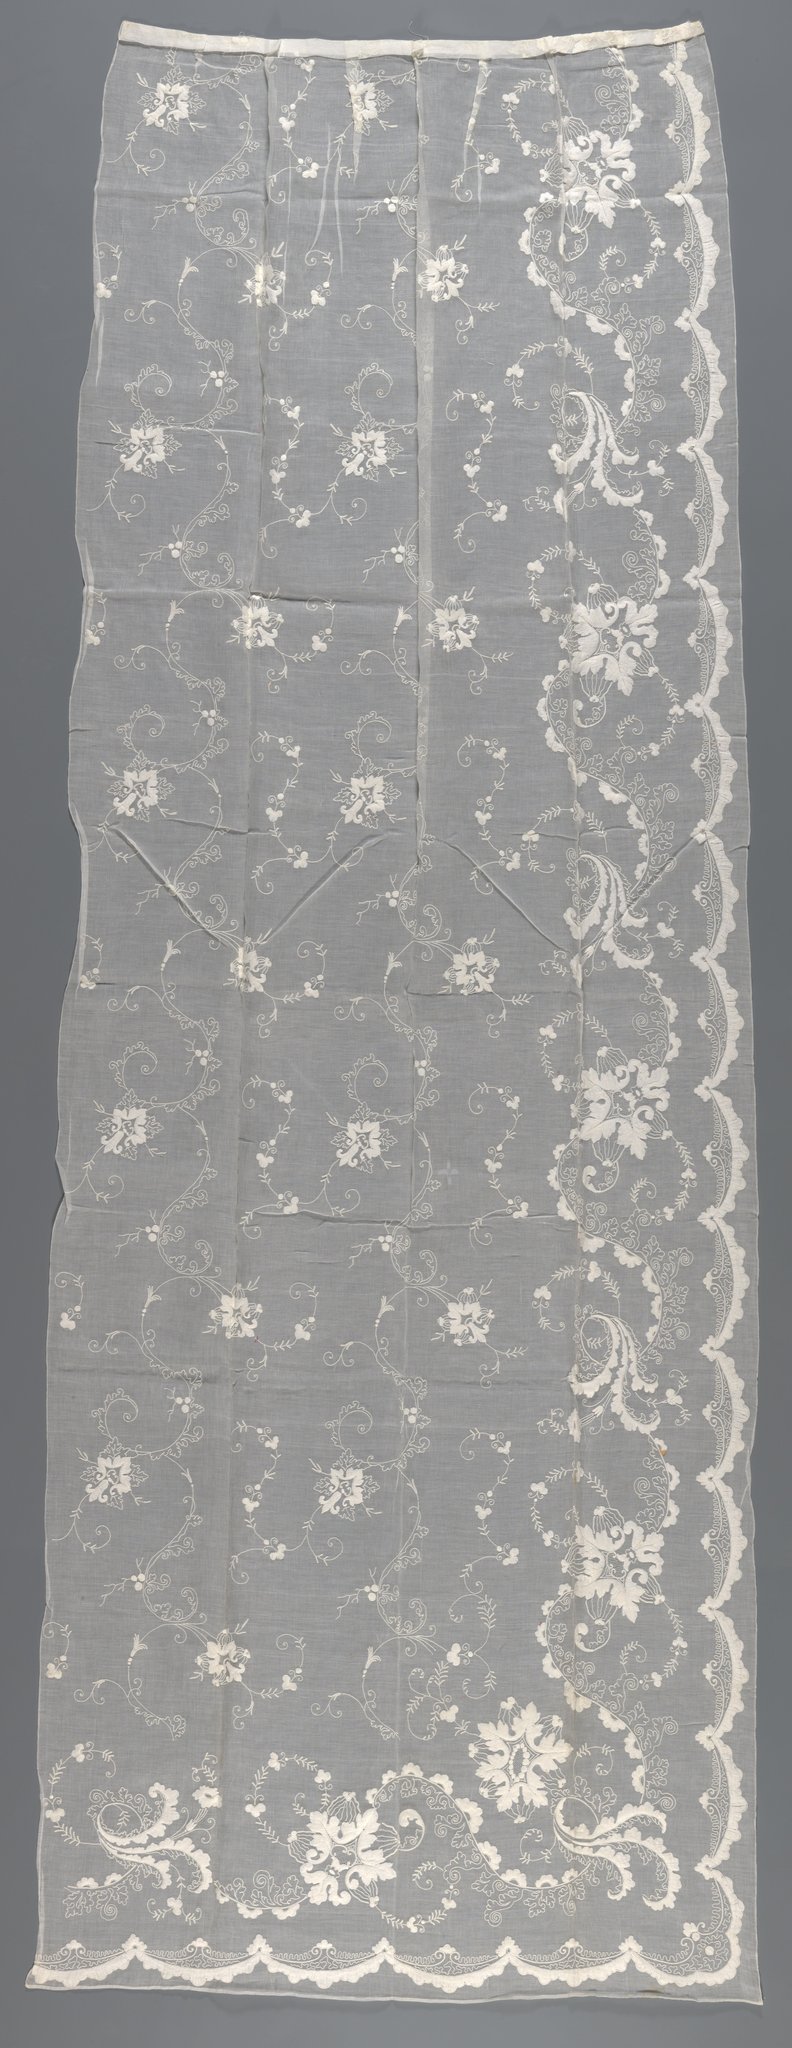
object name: bed curtain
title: Bedgordijn van glasbatist, versierd met tule doorstopborduursel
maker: Anonymous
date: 1800-1874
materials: textile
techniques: stopwork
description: Bedgordijn van glasbatist, versierd met tule doorstopborduursel (wit op wit) in de vorm van bloemornament en voluten.